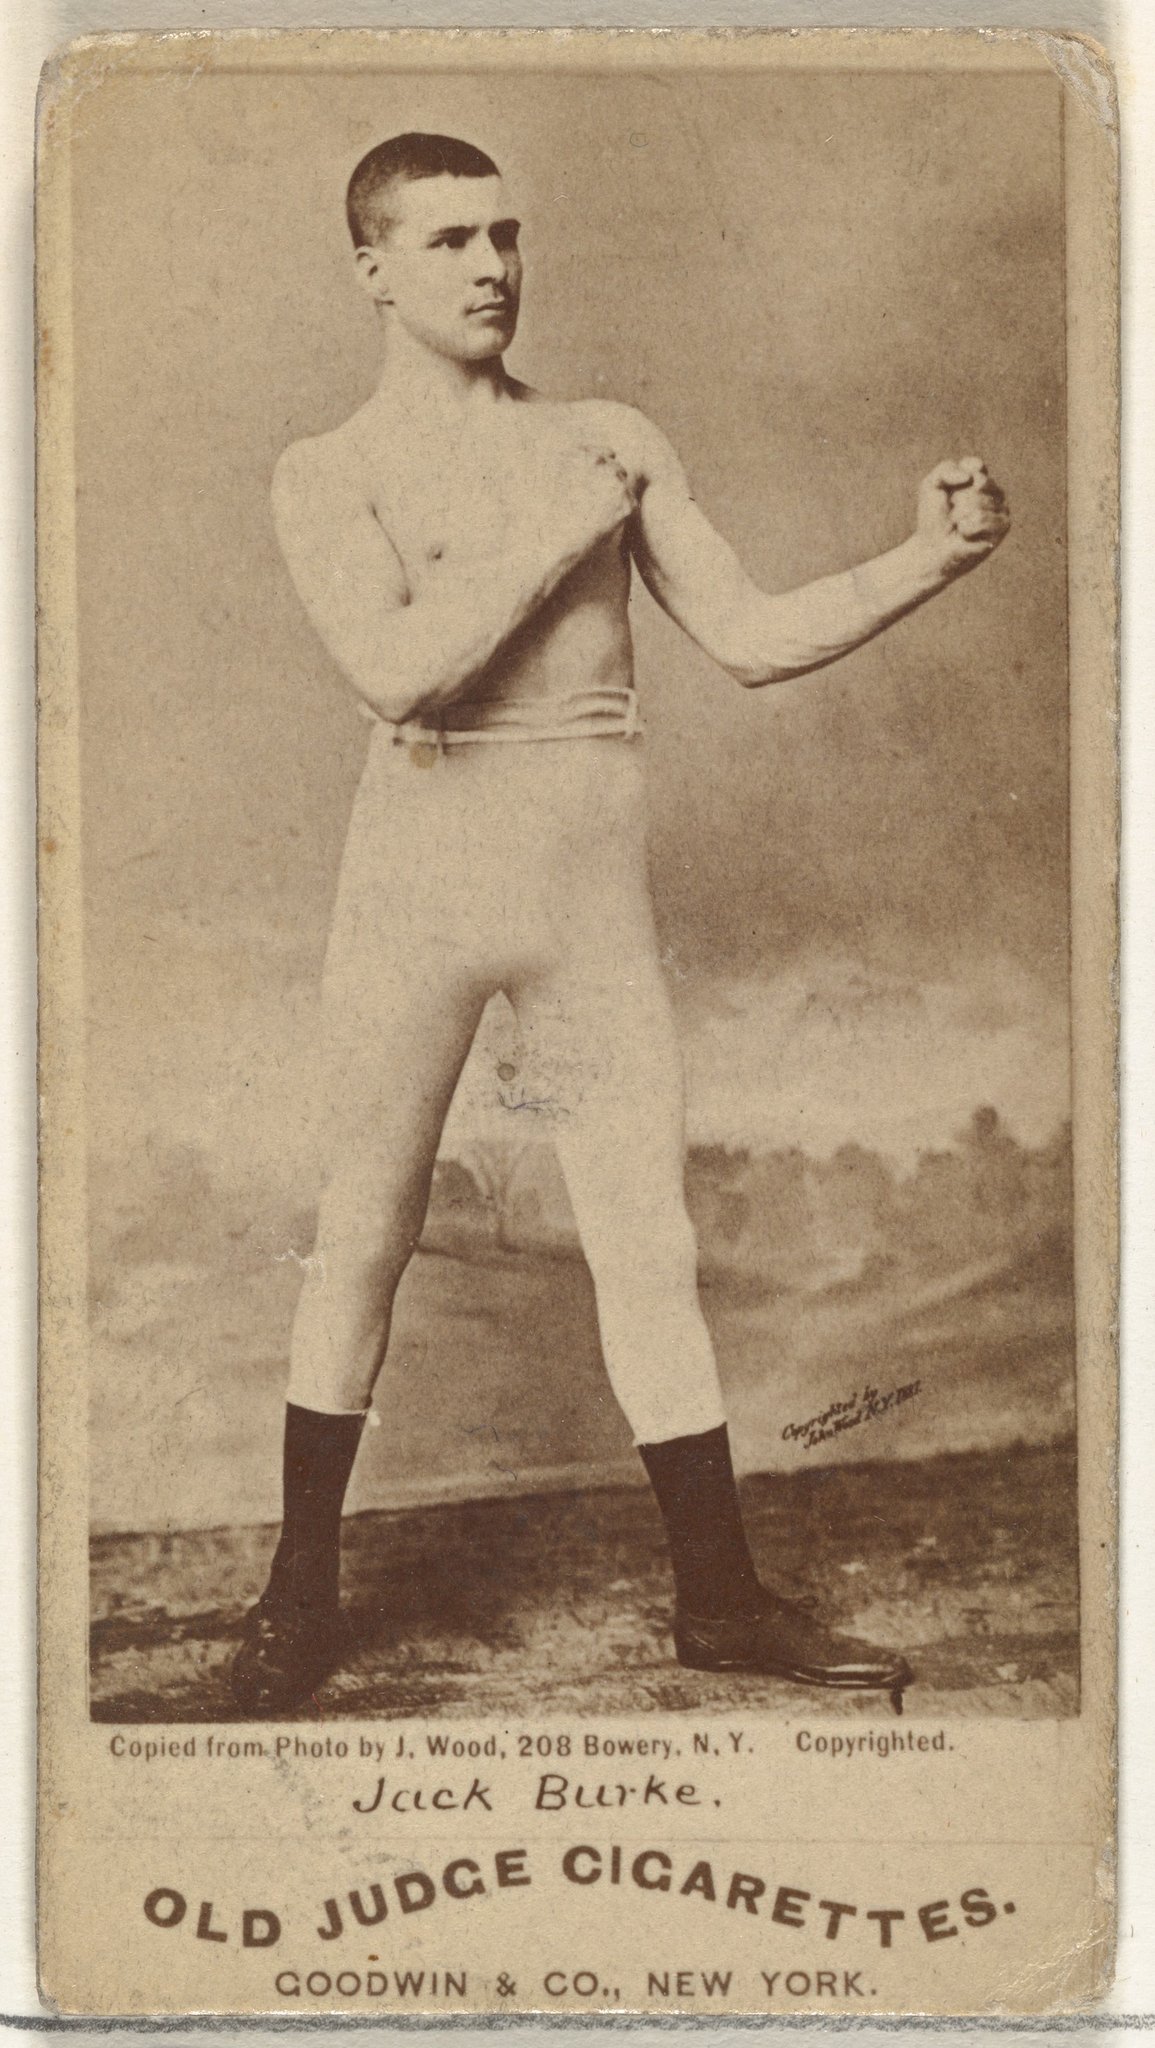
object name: photograph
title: Jack Burke, from the Celebrities and Prizefighters series (N174) for Old Judge Cigarettes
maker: goodwin & company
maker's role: publisher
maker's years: 1850-1950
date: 1887-1888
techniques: albumen silver print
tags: men,portraits,baseball,athletes